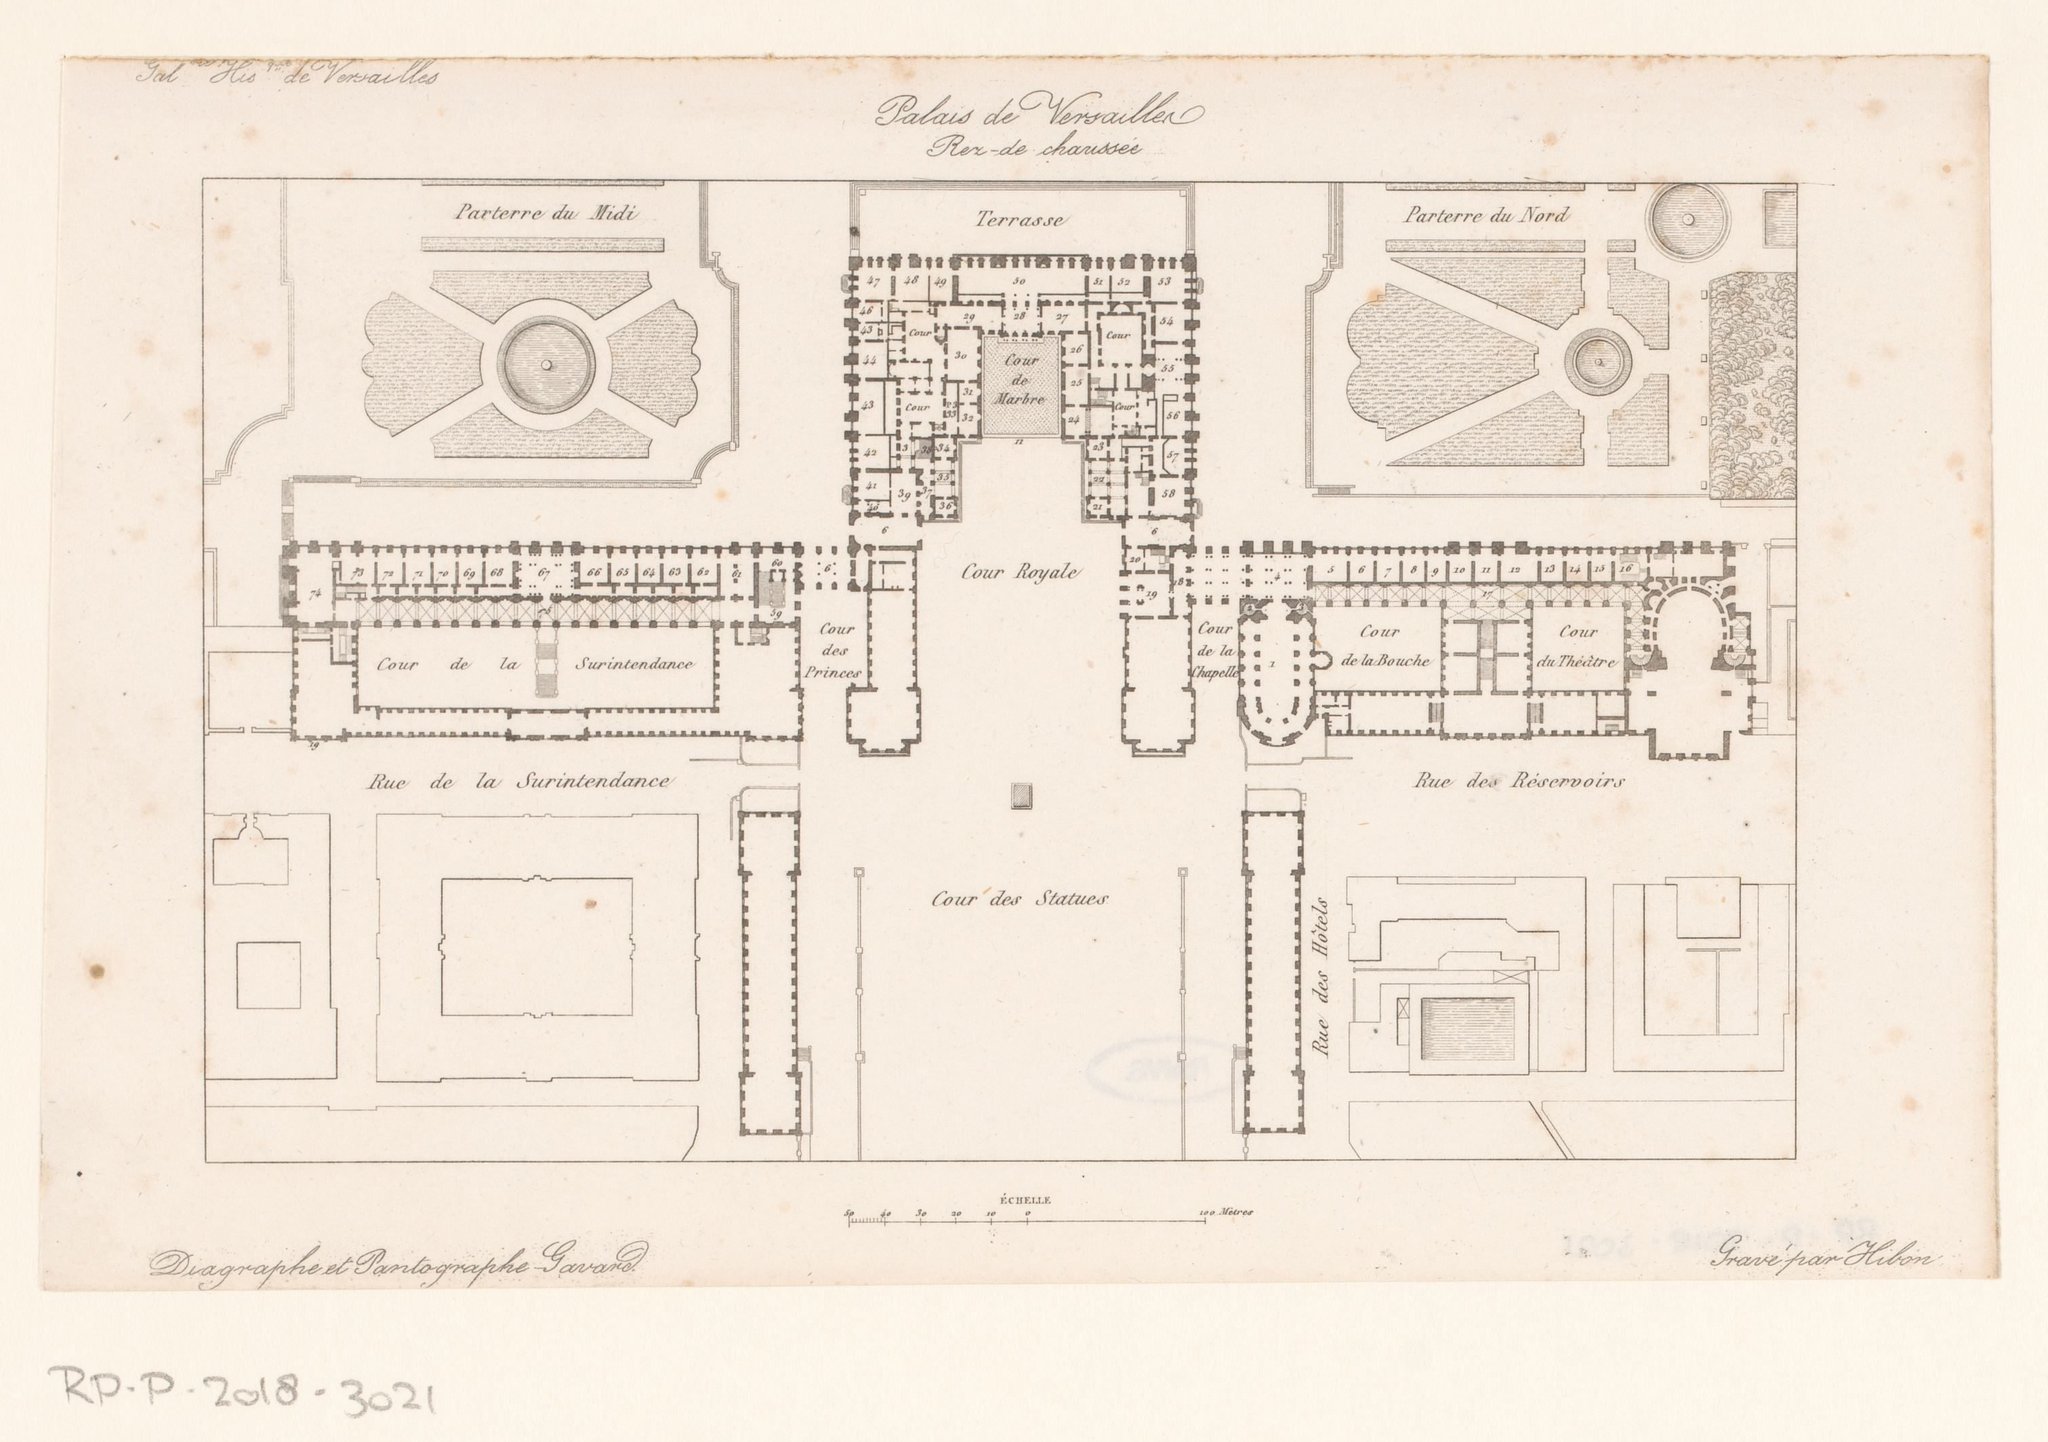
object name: print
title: Plattegrond van de begane grond van het Paleis van Versailles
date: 1840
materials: paper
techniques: engraving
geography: paris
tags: palace, landscape with tower or castle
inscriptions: collector's mark: Lugt 2228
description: Prent uit: Gavard, Charles. Galeries historiques de Versailles, collection de gravures (...). Parijs: Charles Gavard, 1840. Op de prent vermeld: Diagraphe et Pantographe Gavard.